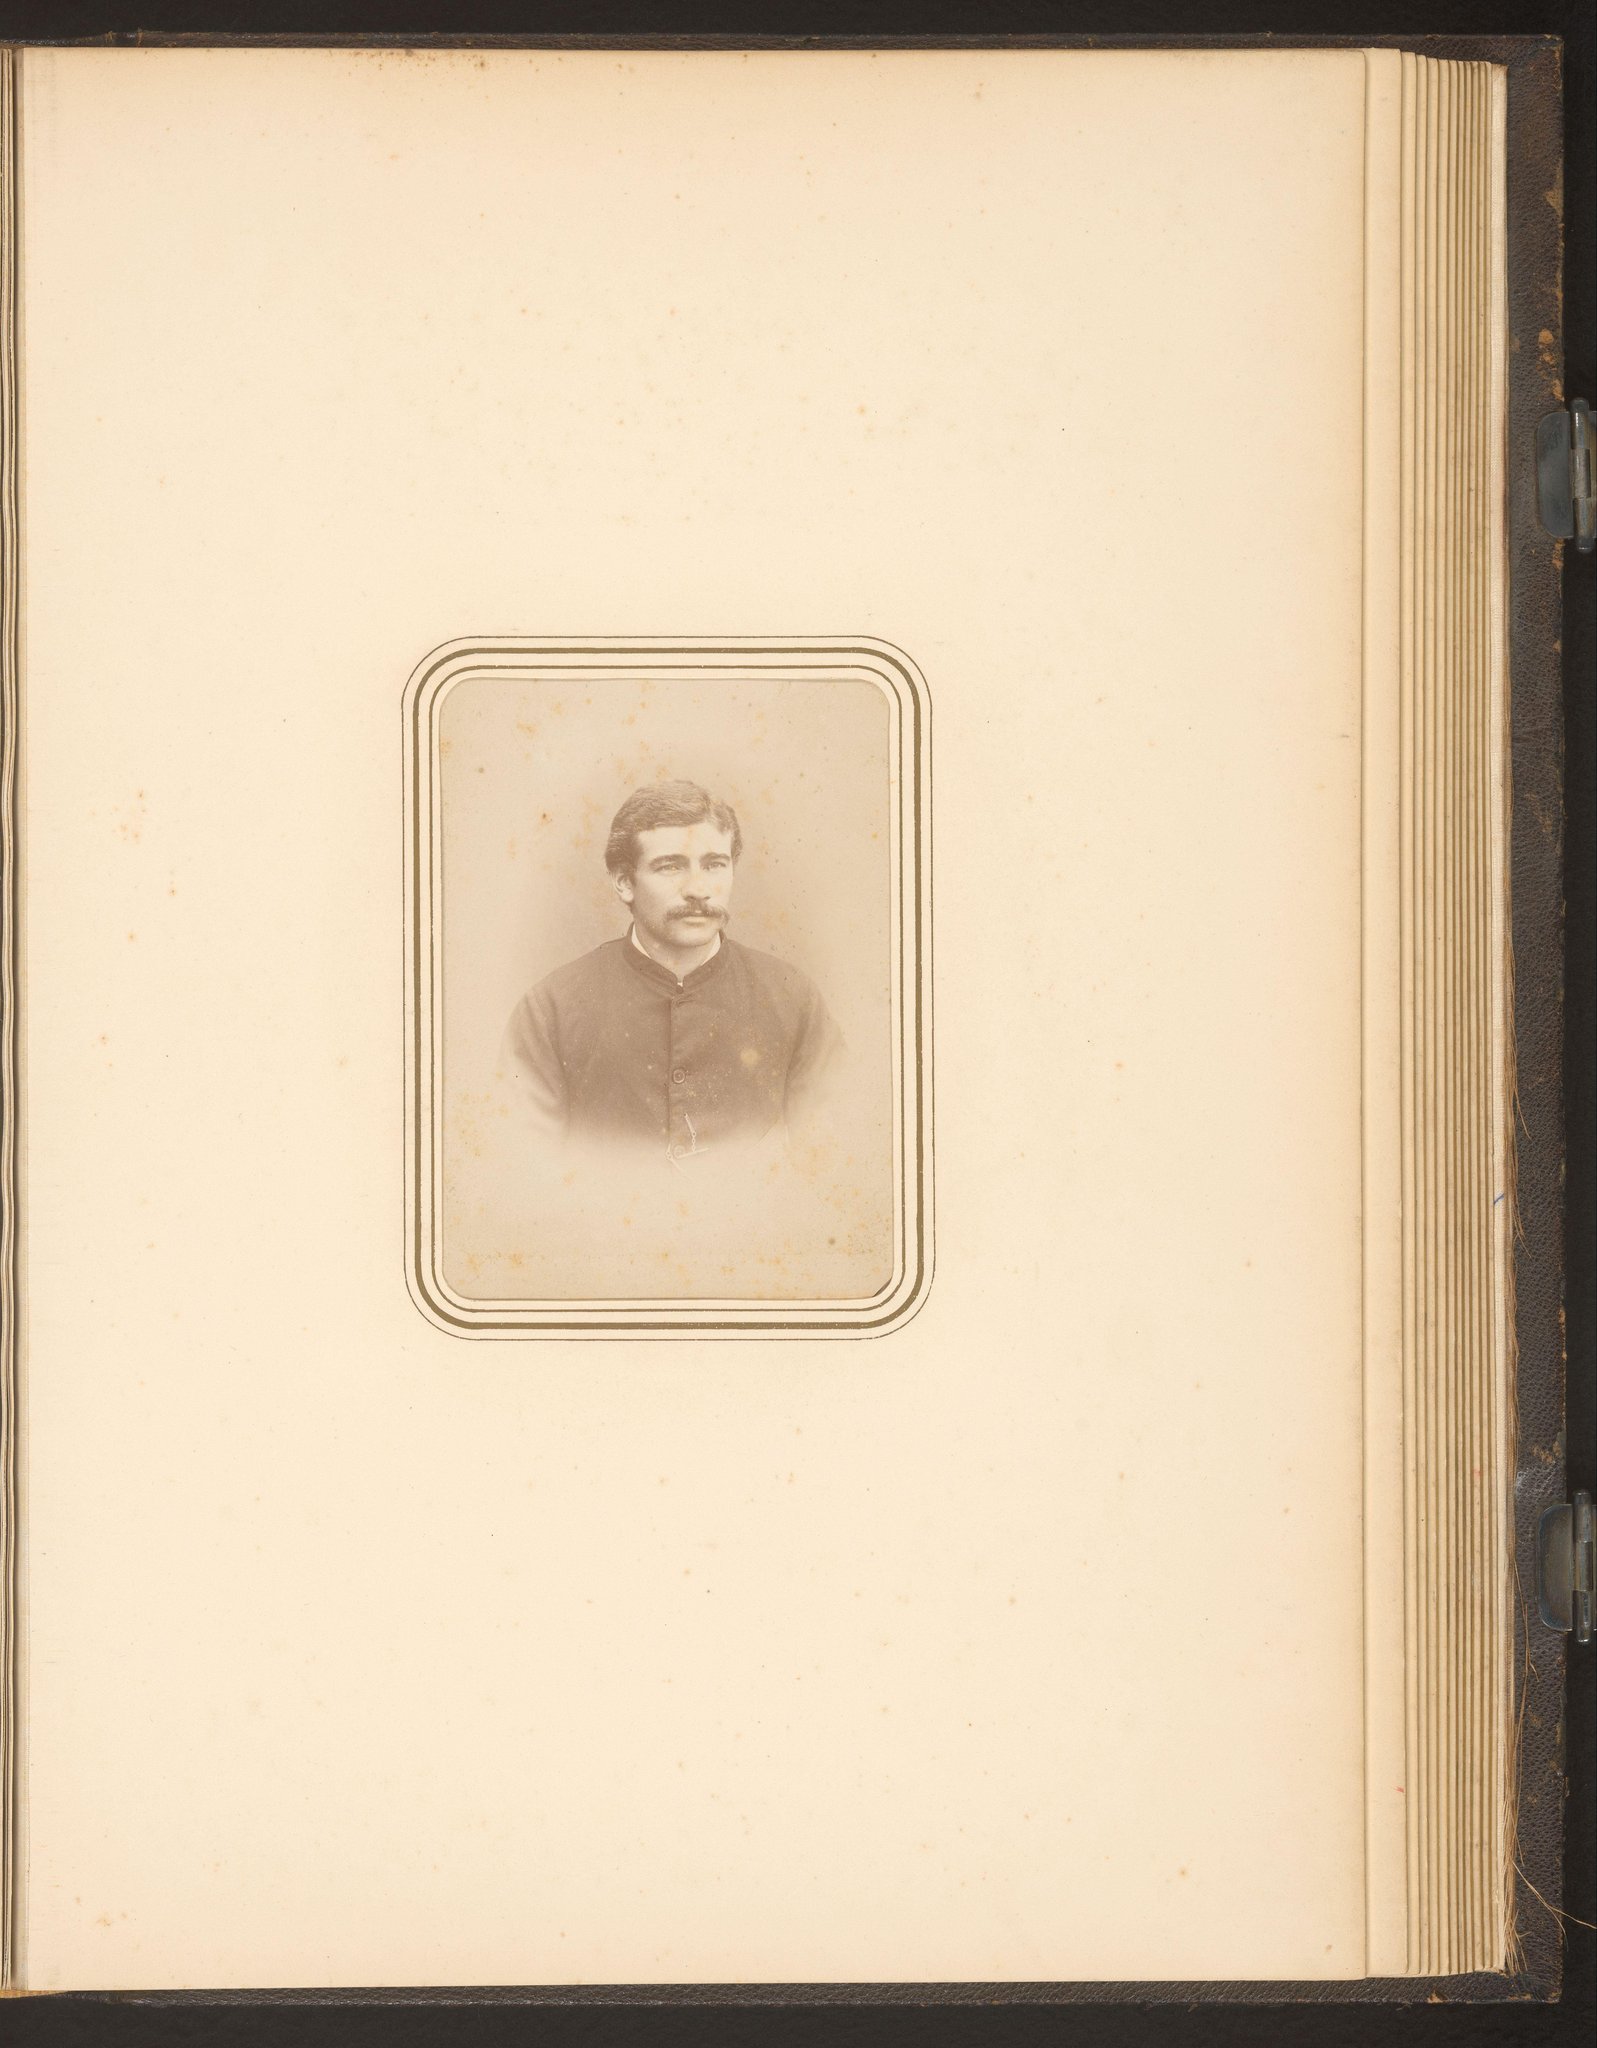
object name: cabinet photograph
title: Portret van onbekende man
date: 1882-1887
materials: cardboard, photographic support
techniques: albumen print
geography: sumatra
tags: historical persons not known by name, sumatra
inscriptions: name: ‘H. Ernst & Co. Photographers Medan Deli Sumatra’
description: Portret van een onbekende man. Ingestoken foto in het herinneringsalbum aangeboden door de Tabak Maatschappij Arendsburg aan hoofdadministrateur M.J. Tiele bij zijn terugkeer naar Nederland in 1887.